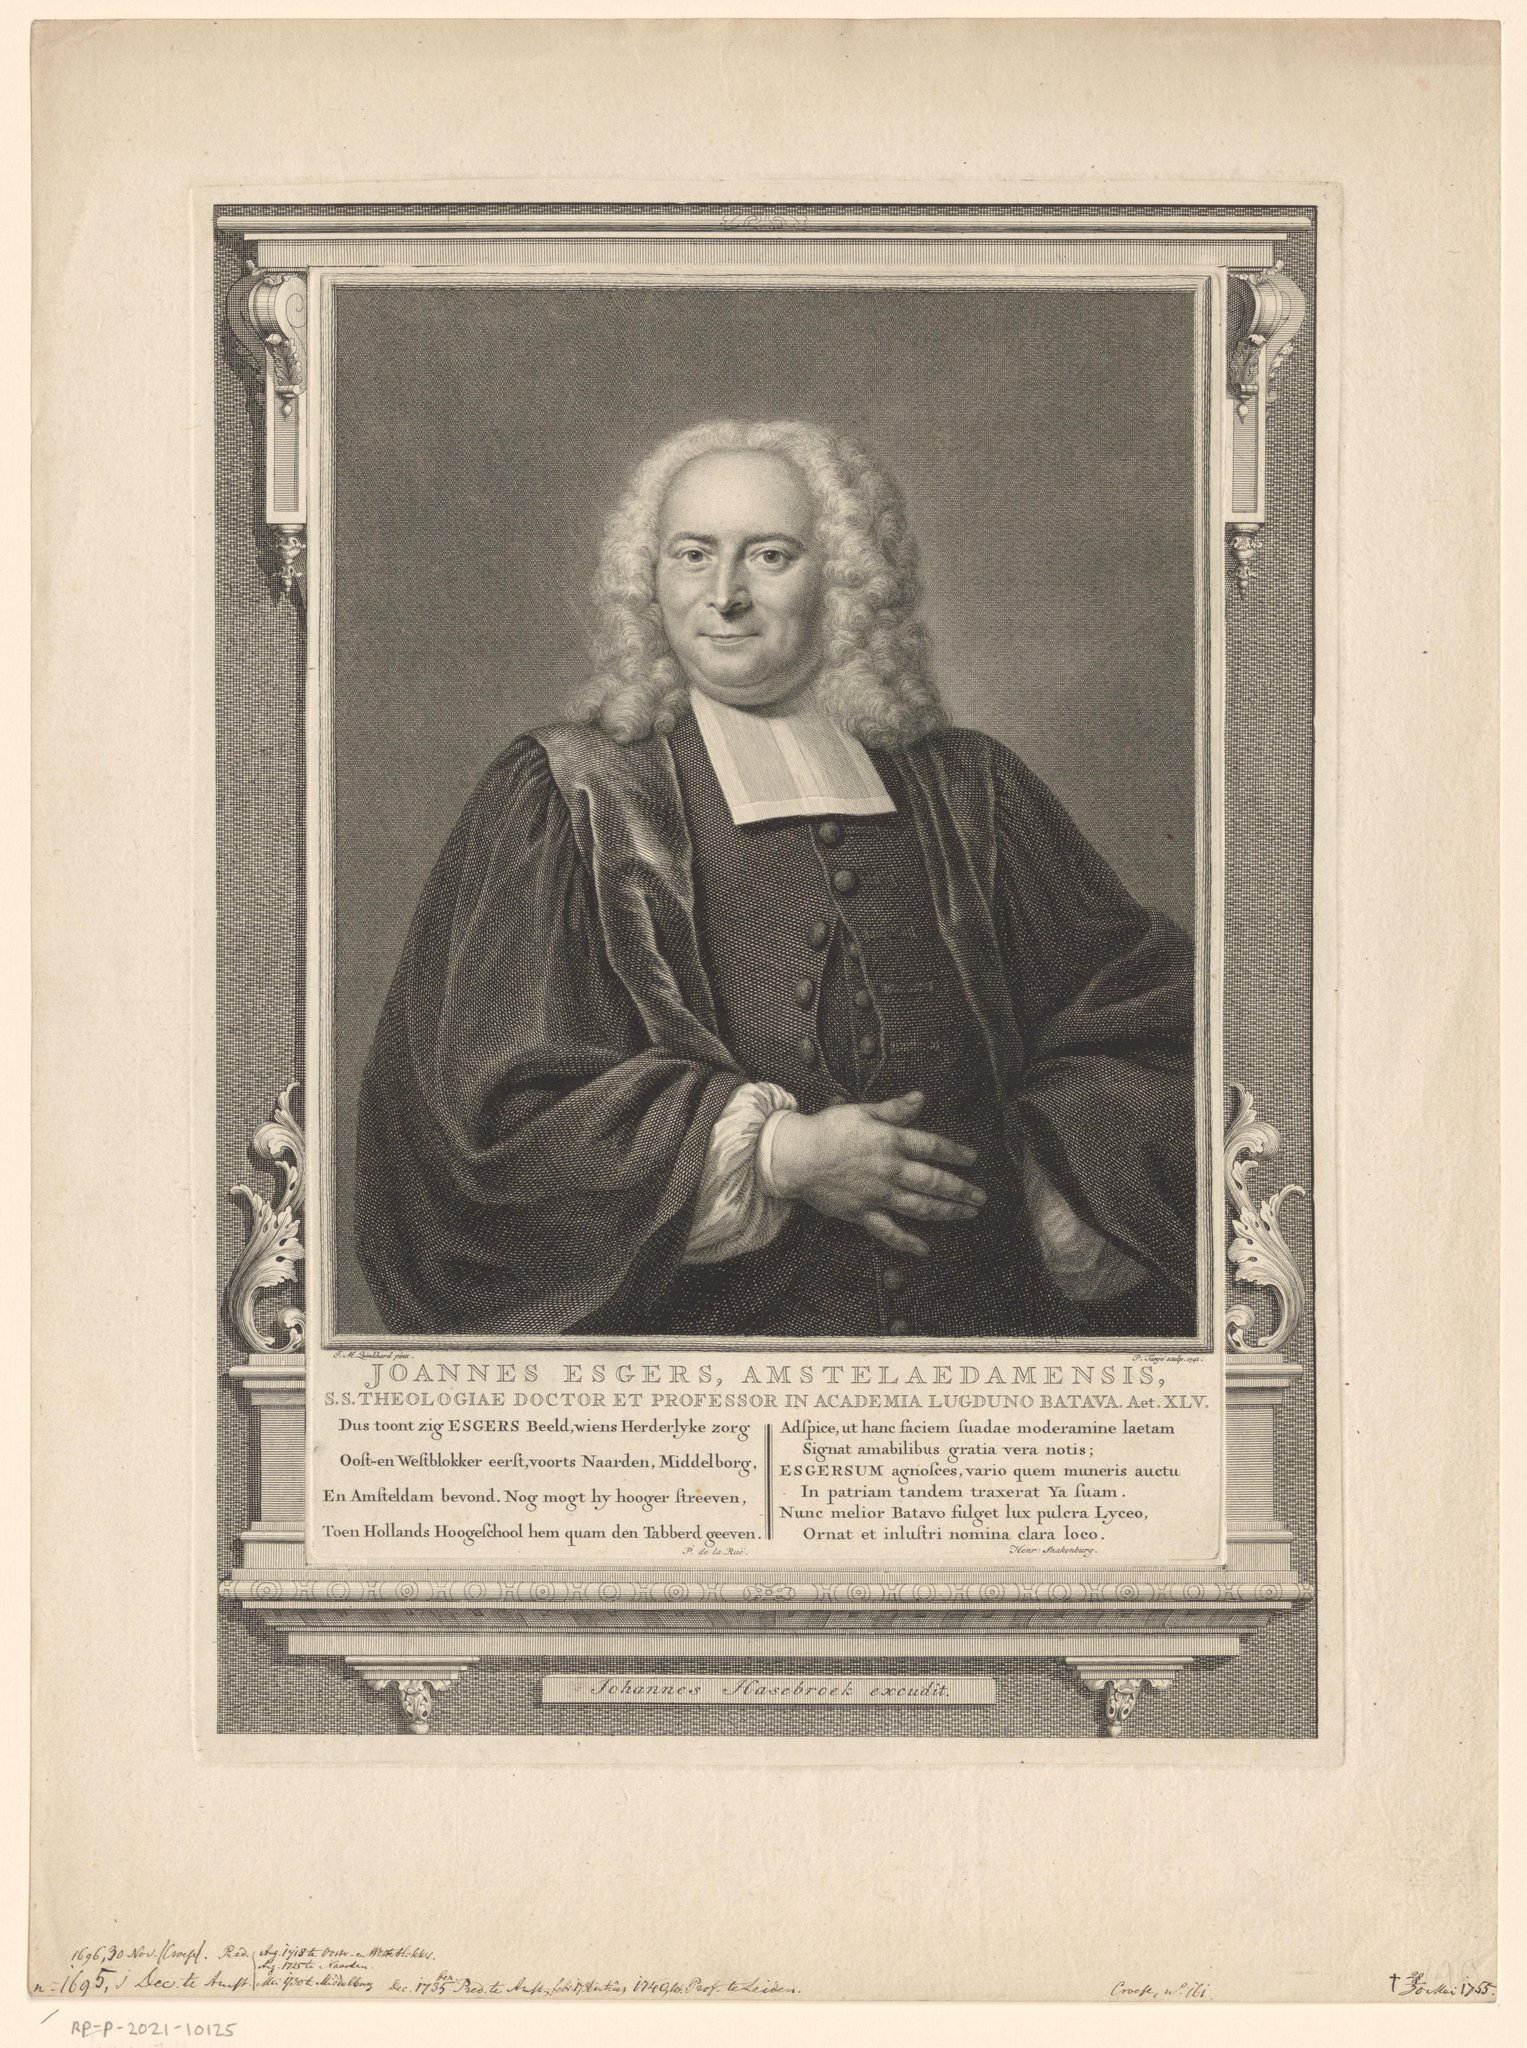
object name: print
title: Portret van Johannes Esgers op 45-jarige leeftijd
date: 1741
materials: paper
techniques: engraving, etching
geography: leiden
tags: leiden, historical persons, professor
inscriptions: inscription: ‘kelder-/ uit dépôt 2002’, inscription: ‘n. 1695, 1 dec te Amst. (...)’, collector's mark: Lugt 2228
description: Met vierregelig vers in het Nederlands en zesregelig vers in het Latijn onder het portret.